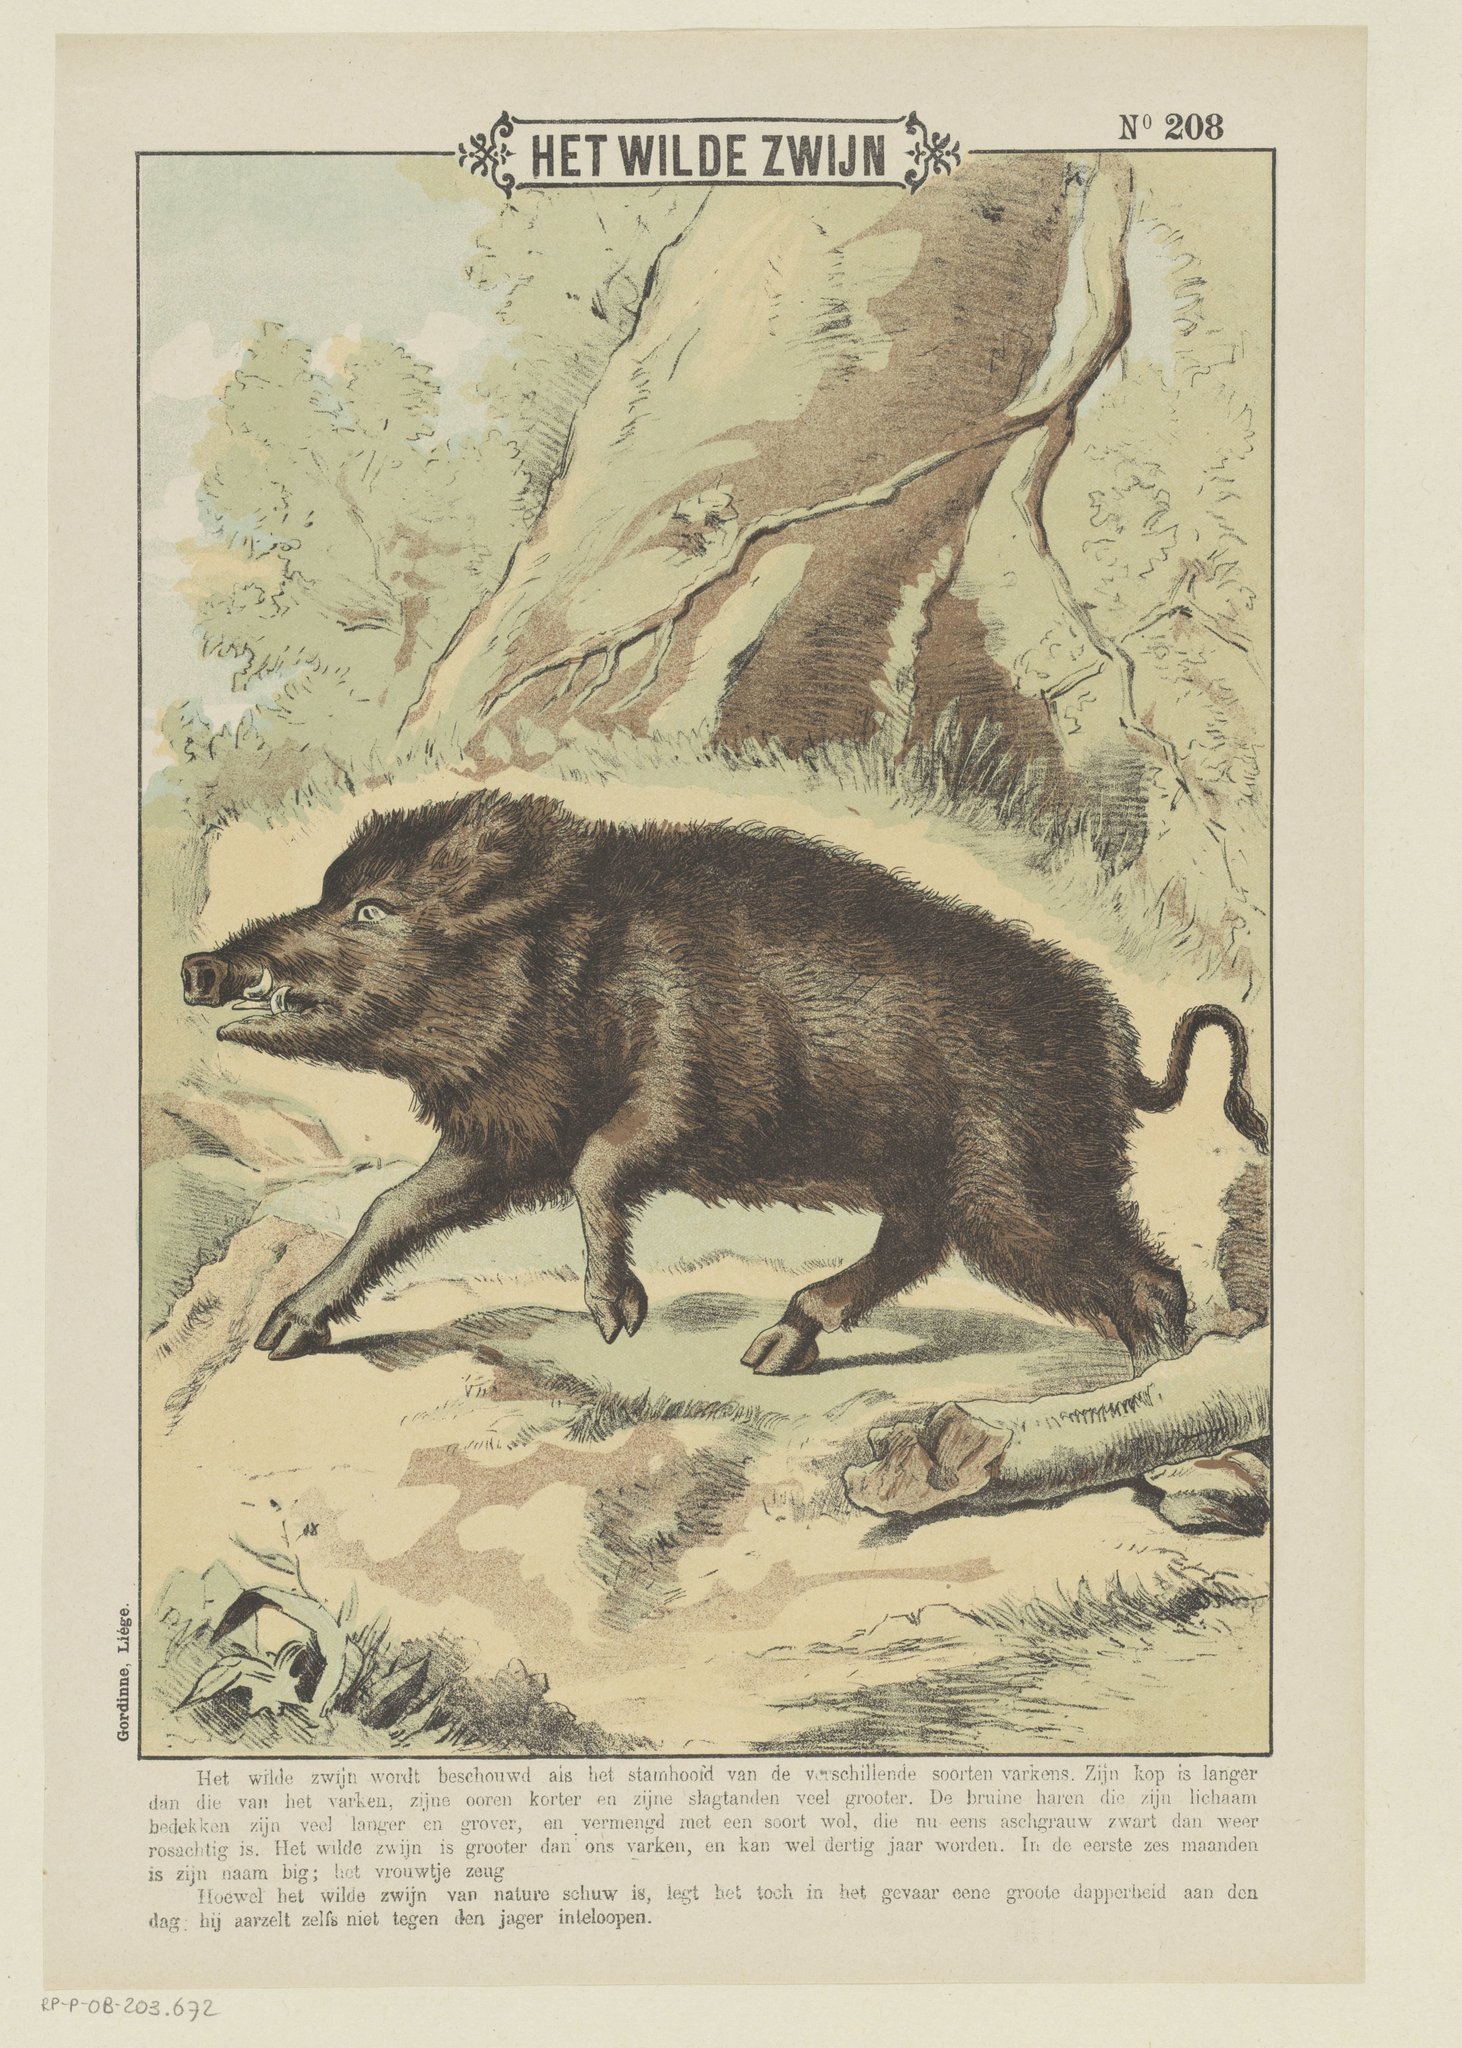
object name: print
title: Het wilde zwijn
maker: Anonymous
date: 1894-1959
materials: paper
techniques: lithograph, letterpress printing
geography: liège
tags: hoofed animals: boar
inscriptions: collector's mark: Lugt 2760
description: Blad met een grote voorstelling van een wild zwijn. In de ondermarge een onderschrift. Genummerd rechtsboven: No 208.